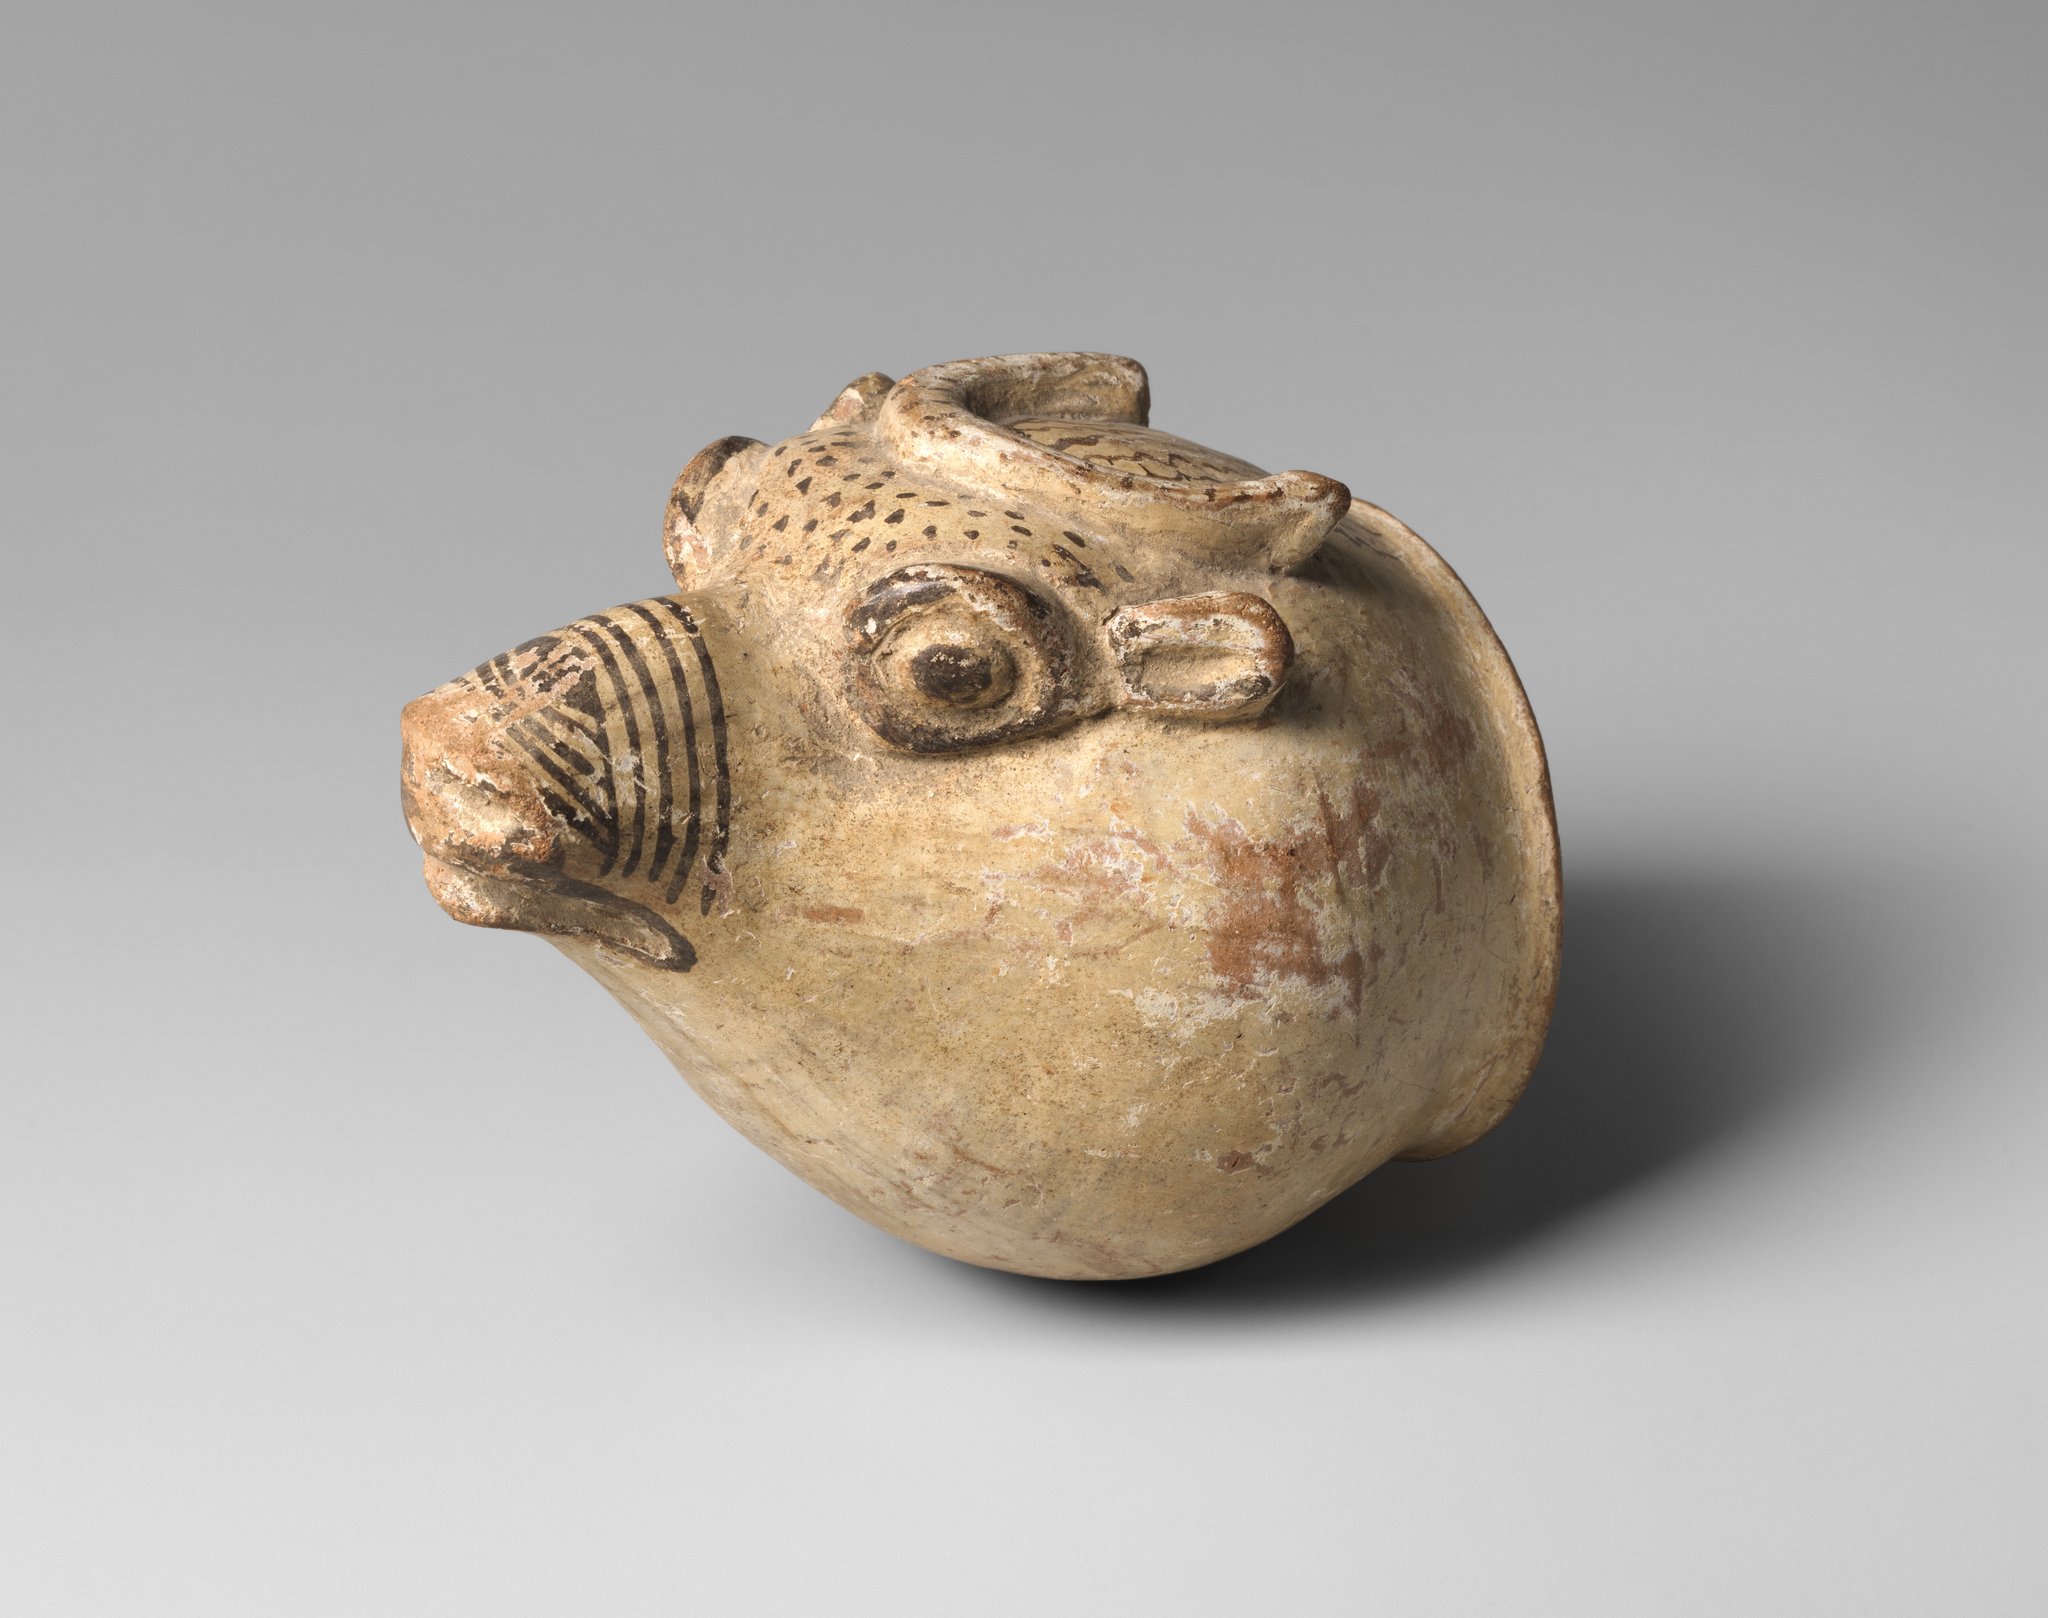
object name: vessel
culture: old assyrian or hittite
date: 1900-1600 BCE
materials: ceramic, paint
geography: central anatolia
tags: rams